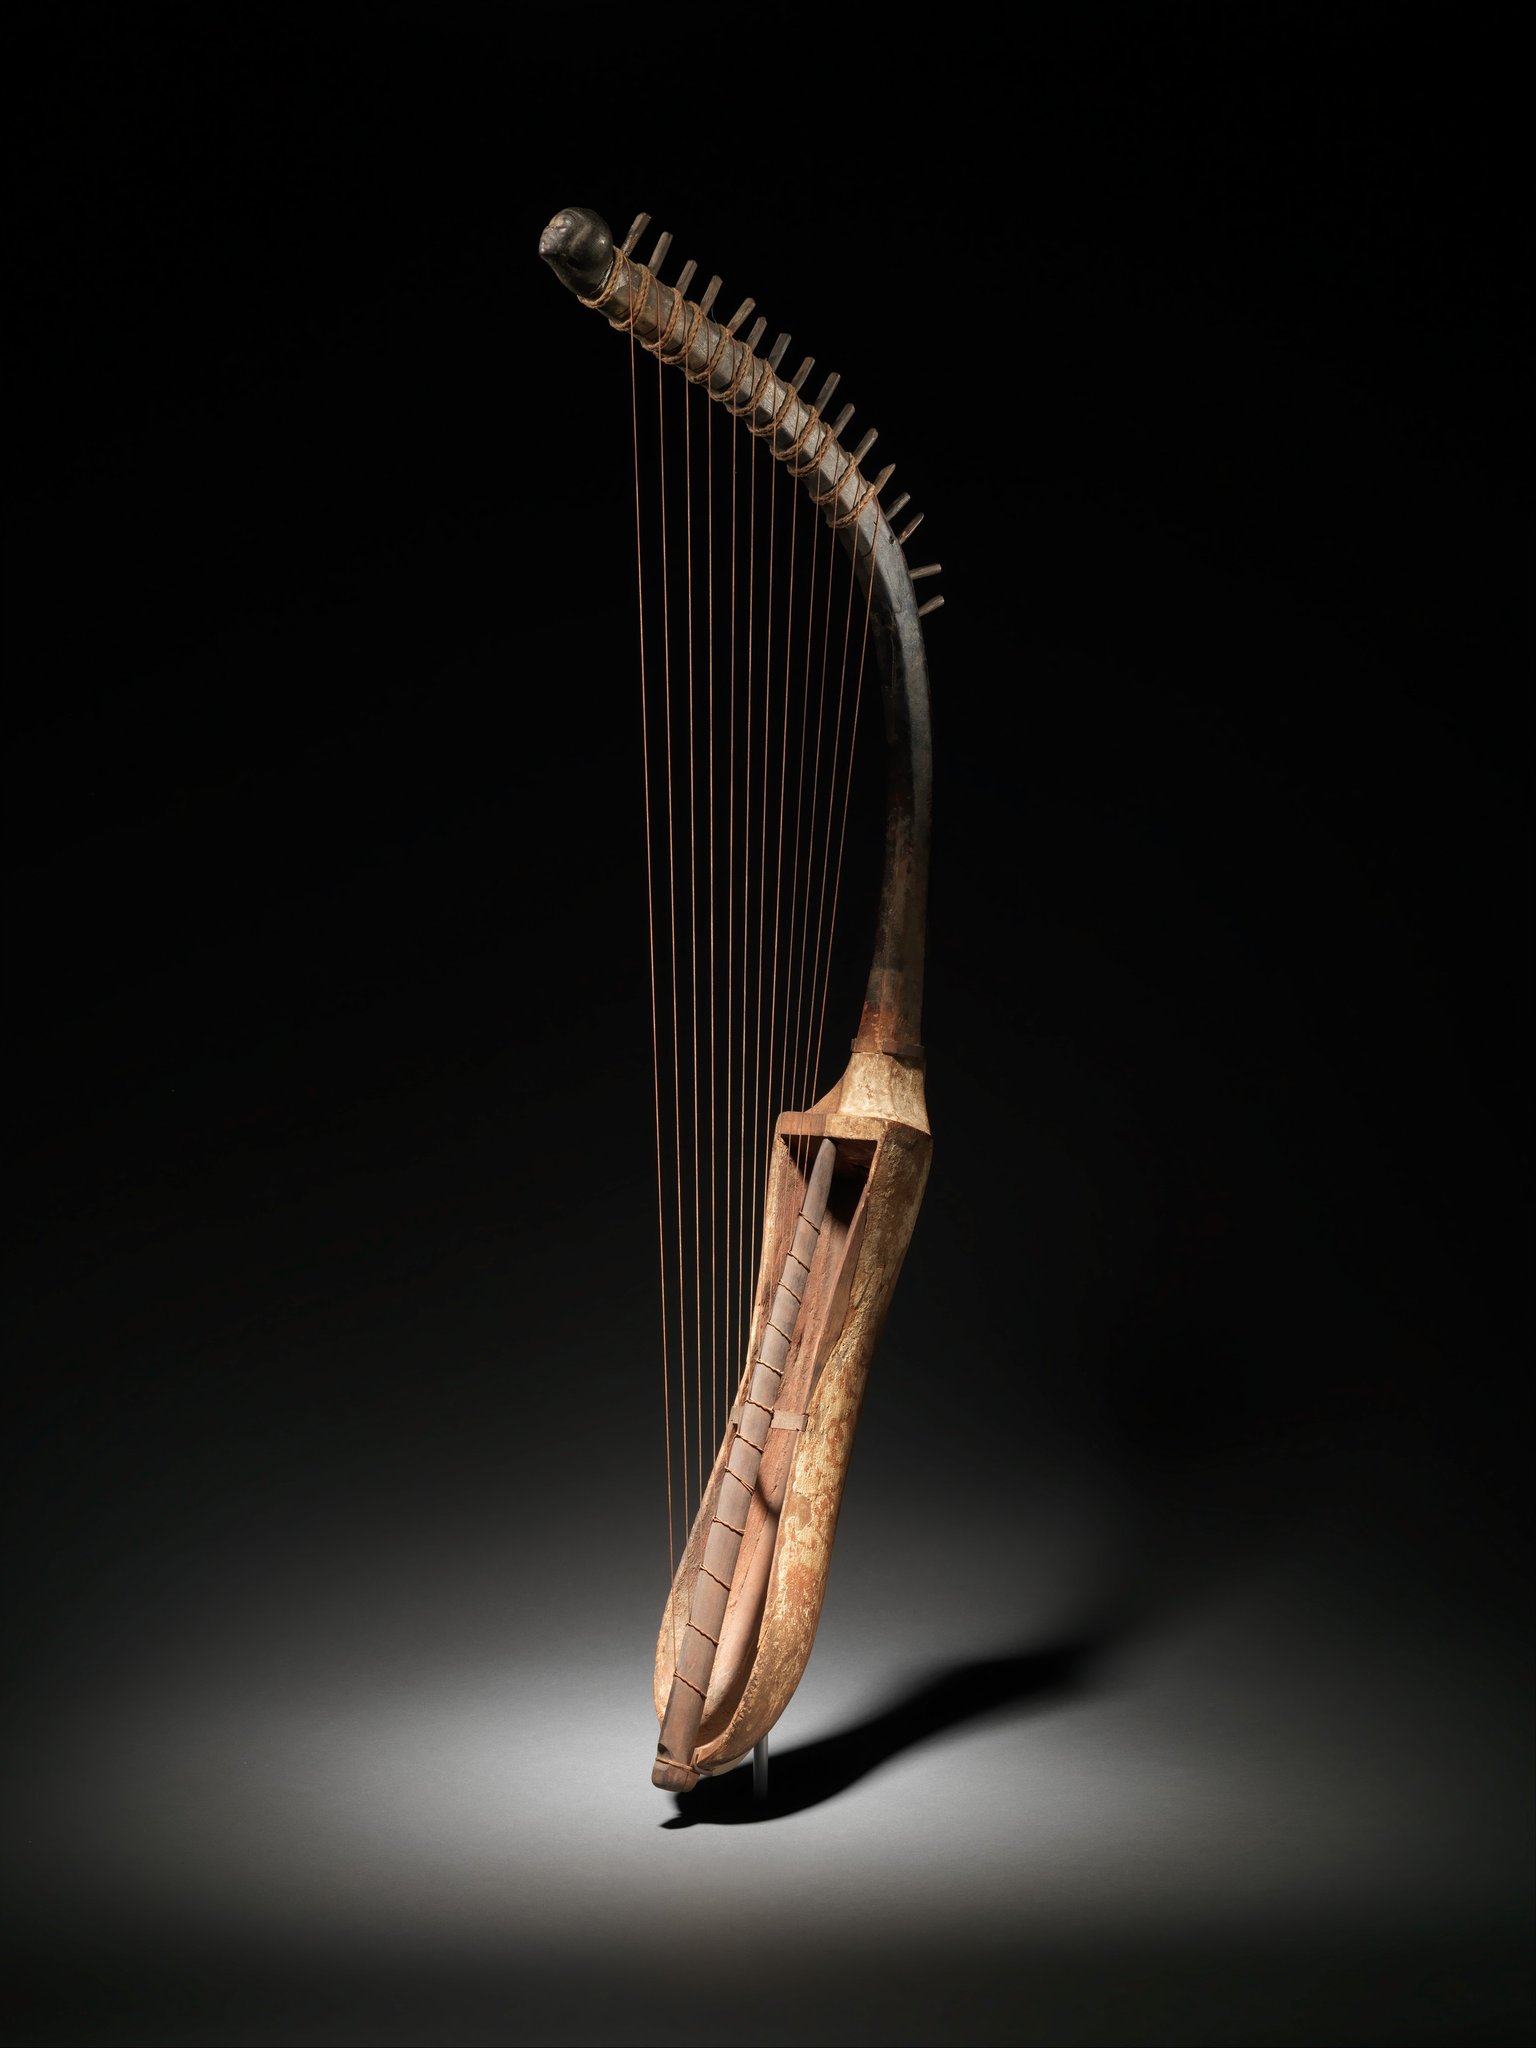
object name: music, harp, arched, naviform, boat shaped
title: Arched Harp (shoulder harp)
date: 1390-1295 BCE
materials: wood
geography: egypt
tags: musical instruments